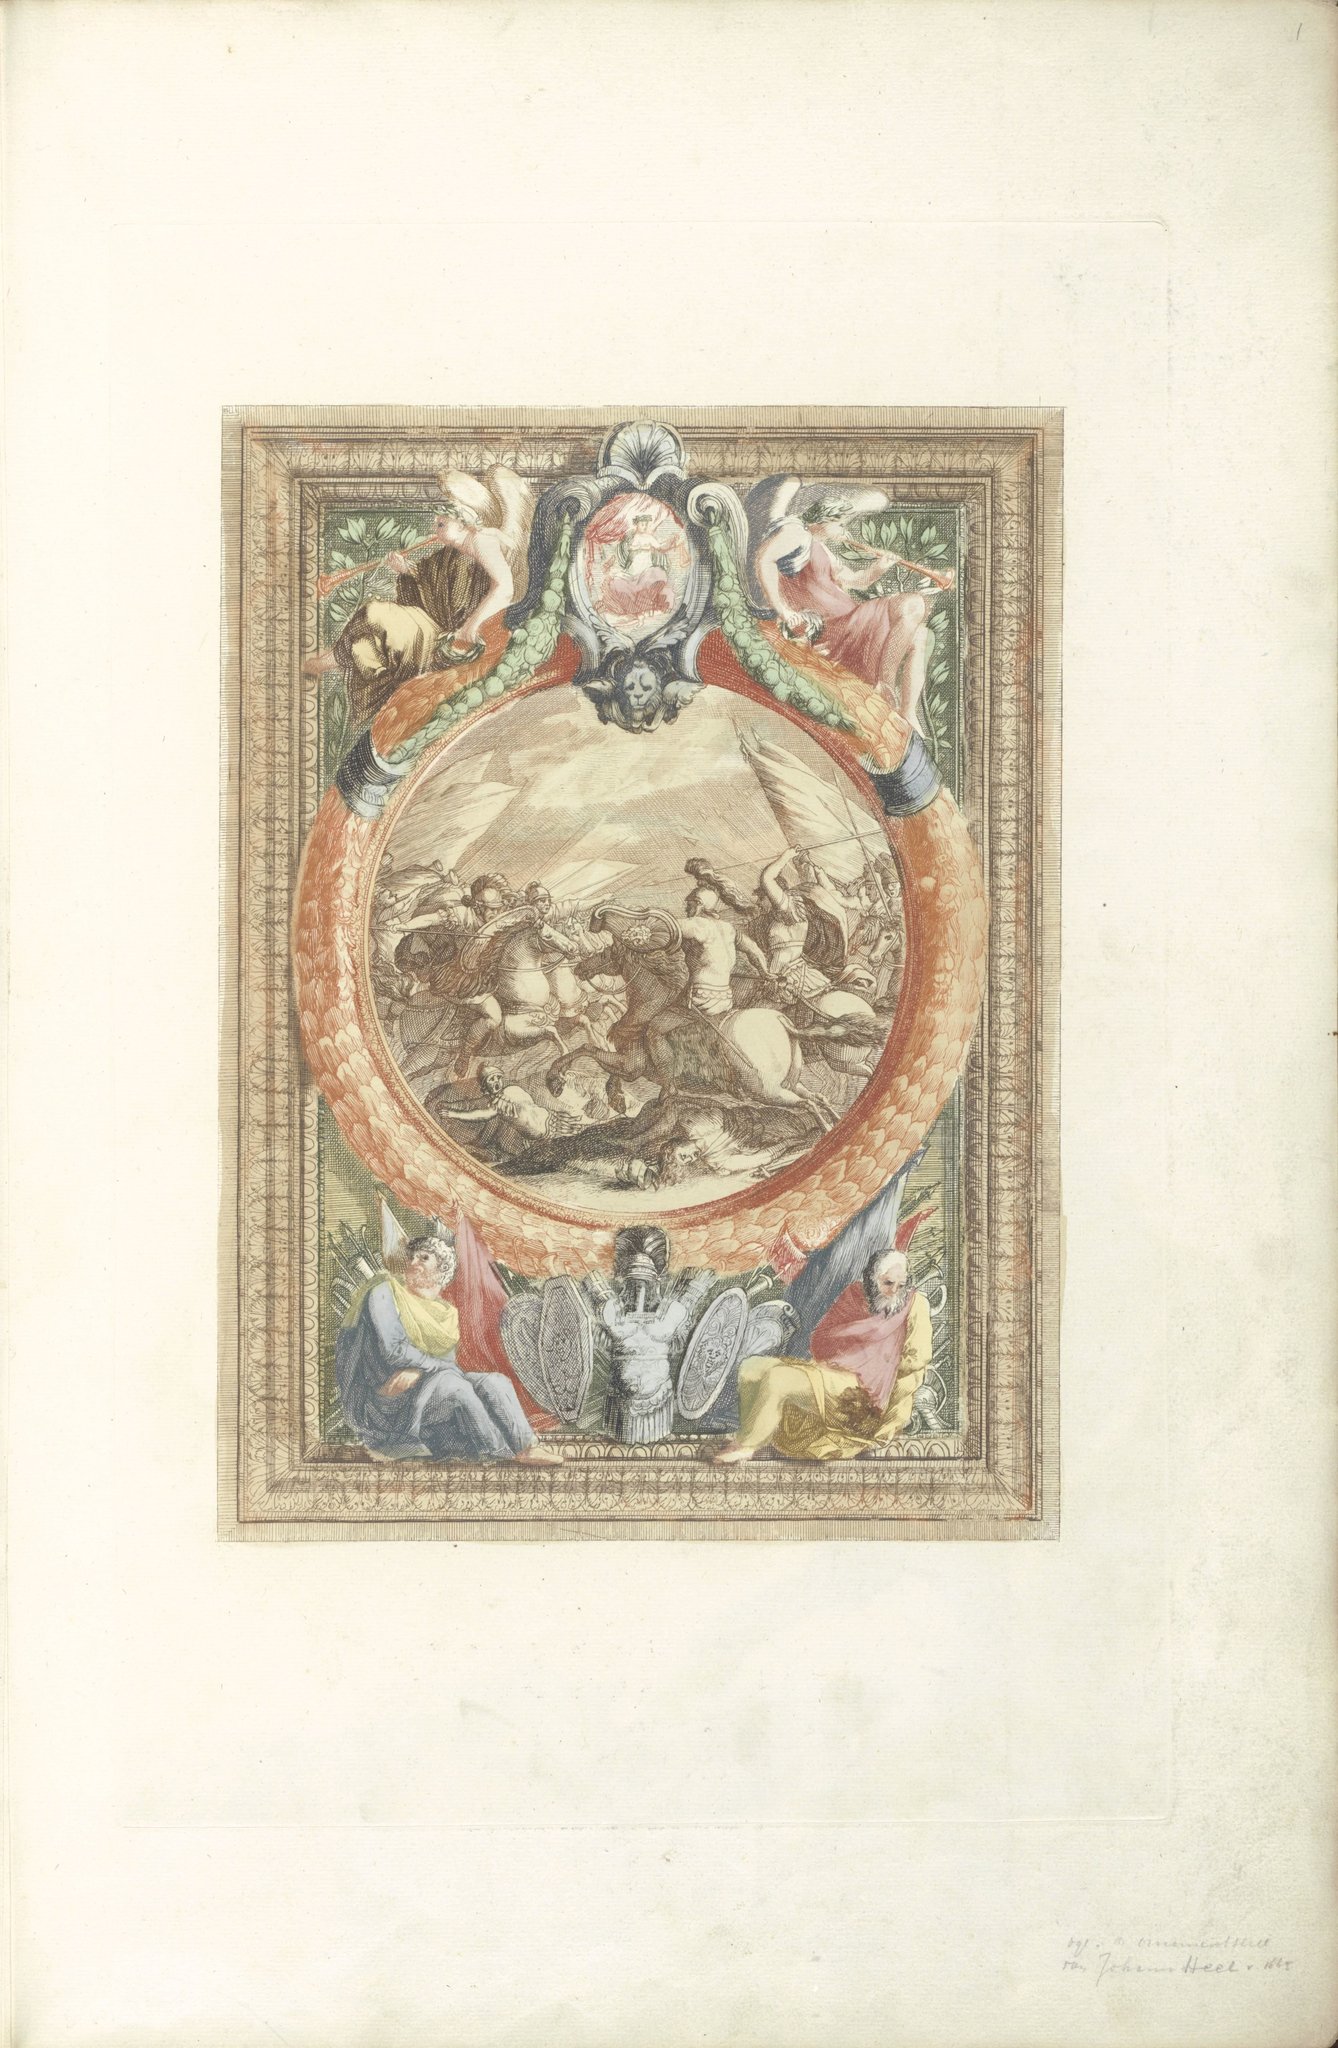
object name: album leaf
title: Ruitergevecht in ornamentele omlijsting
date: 1688-1698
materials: paper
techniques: etching, hand coloring, lithography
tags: 'tropaion', i.e. decorative ornament ~ weapons, battle (+ cavalry, horsemen), fame; 'fama', 'fama buona', 'fama chiara' (ripa)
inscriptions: inscription: ‘vgl. ornamentserie / van Johann Heel v. 1665’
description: Een ruitergevecht in een omlijsting van een lauwerkrans. Midden boven de personificatie van Rechtvaardigheid met zwaard en weegschaal. Rechts en linksboven blazen personificaties van Faam de loftrompet. Onderaan een wapentrofee en twee gevangenen. Het geheel is gevat in een lijst. Deze prent maakt deel uit van een album.